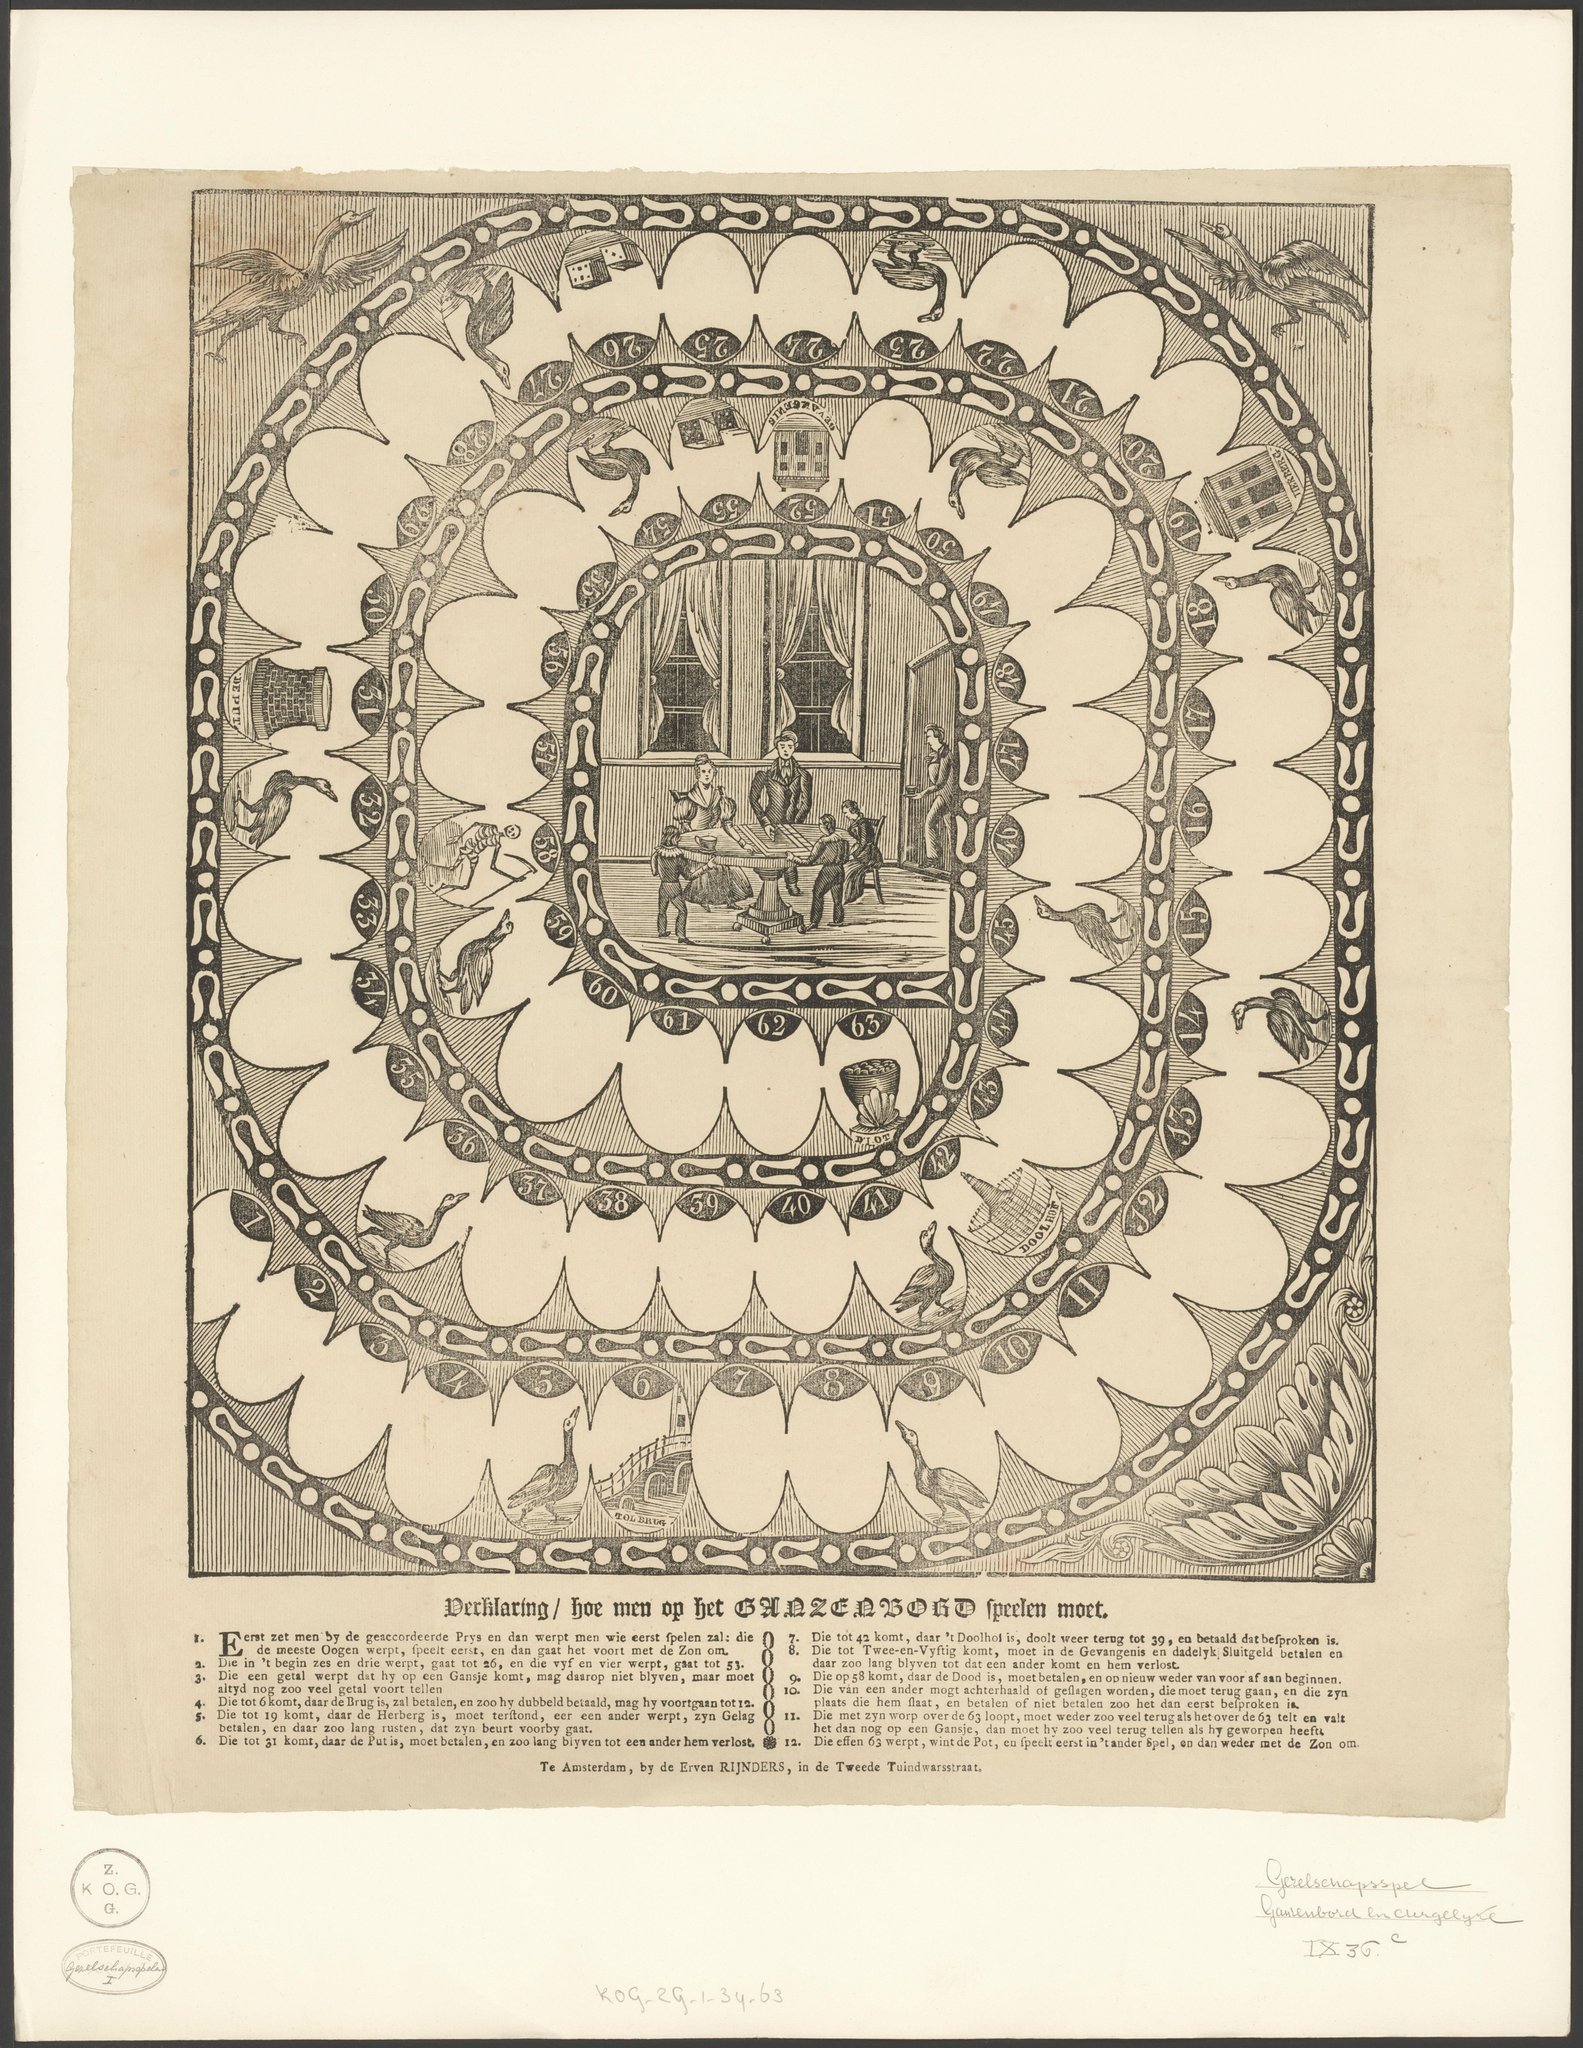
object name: gameboard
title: Ganzenbord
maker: Anonymous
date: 1831-1854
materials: paper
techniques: letterpress printing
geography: amsterdam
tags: goose-game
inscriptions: collector's mark, collector's mark: Lugt 1641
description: Ganzenbordspel met 63 vakjes. In het midden spelen een vader, moeder en drie kinderen aan een tafel het ganzenbordspel. Onder het spel de spelregels 1-12. Onderwerpsrubrieken binnen de Atlas Zeden en Gewoonten: Spel en Vermaak; gezelschapsspel, ganzenbord en dergelijke.